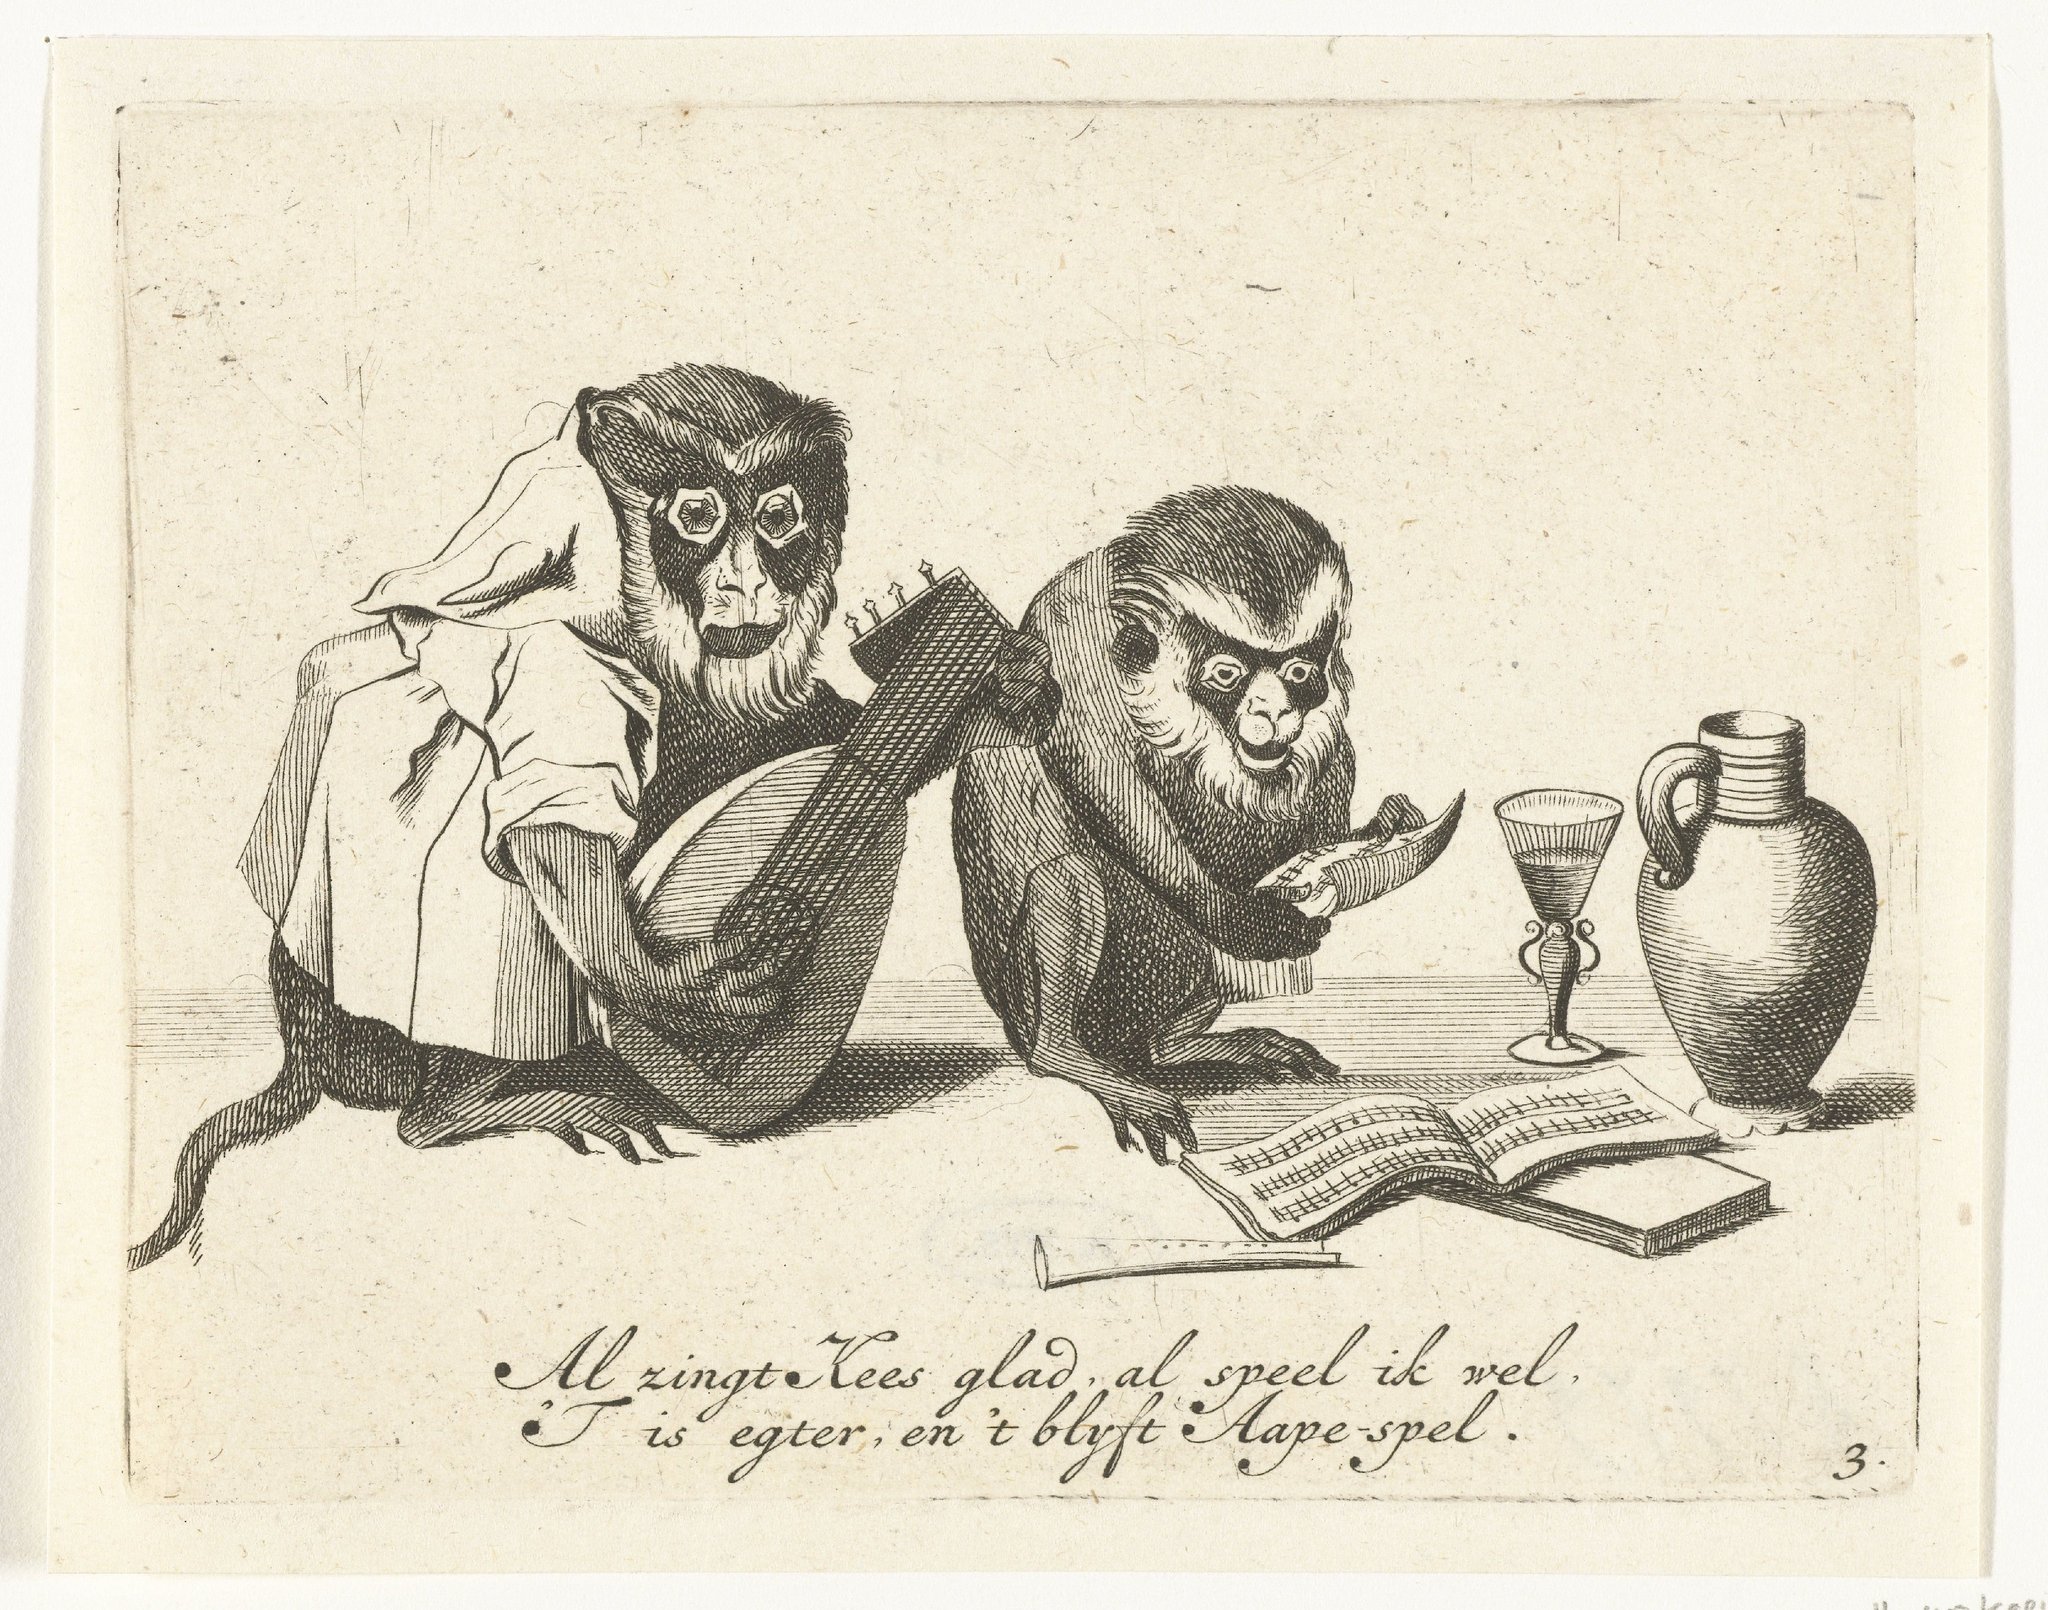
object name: print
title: Wat is 't dat m' in deez' Waereld ziet? / 'T is Aape-spel, en anders niet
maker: Anonymous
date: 1635-1724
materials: paper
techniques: engraving, etching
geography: low countries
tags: animals acting as human beings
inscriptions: collector's mark: Lugt 2228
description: Twee apen hurken op de grond en maken muziek. De ene speelt op een luit en de andere zingt. Prent uit een serie van zes prenten en een titelprent waarin verschillende menselijke bezigheden door apen voorgesteld worden. Kopieën naar prenten van Quirin Boel, met een toegevoegd vers in het Nederlands onder elke voorstelling.